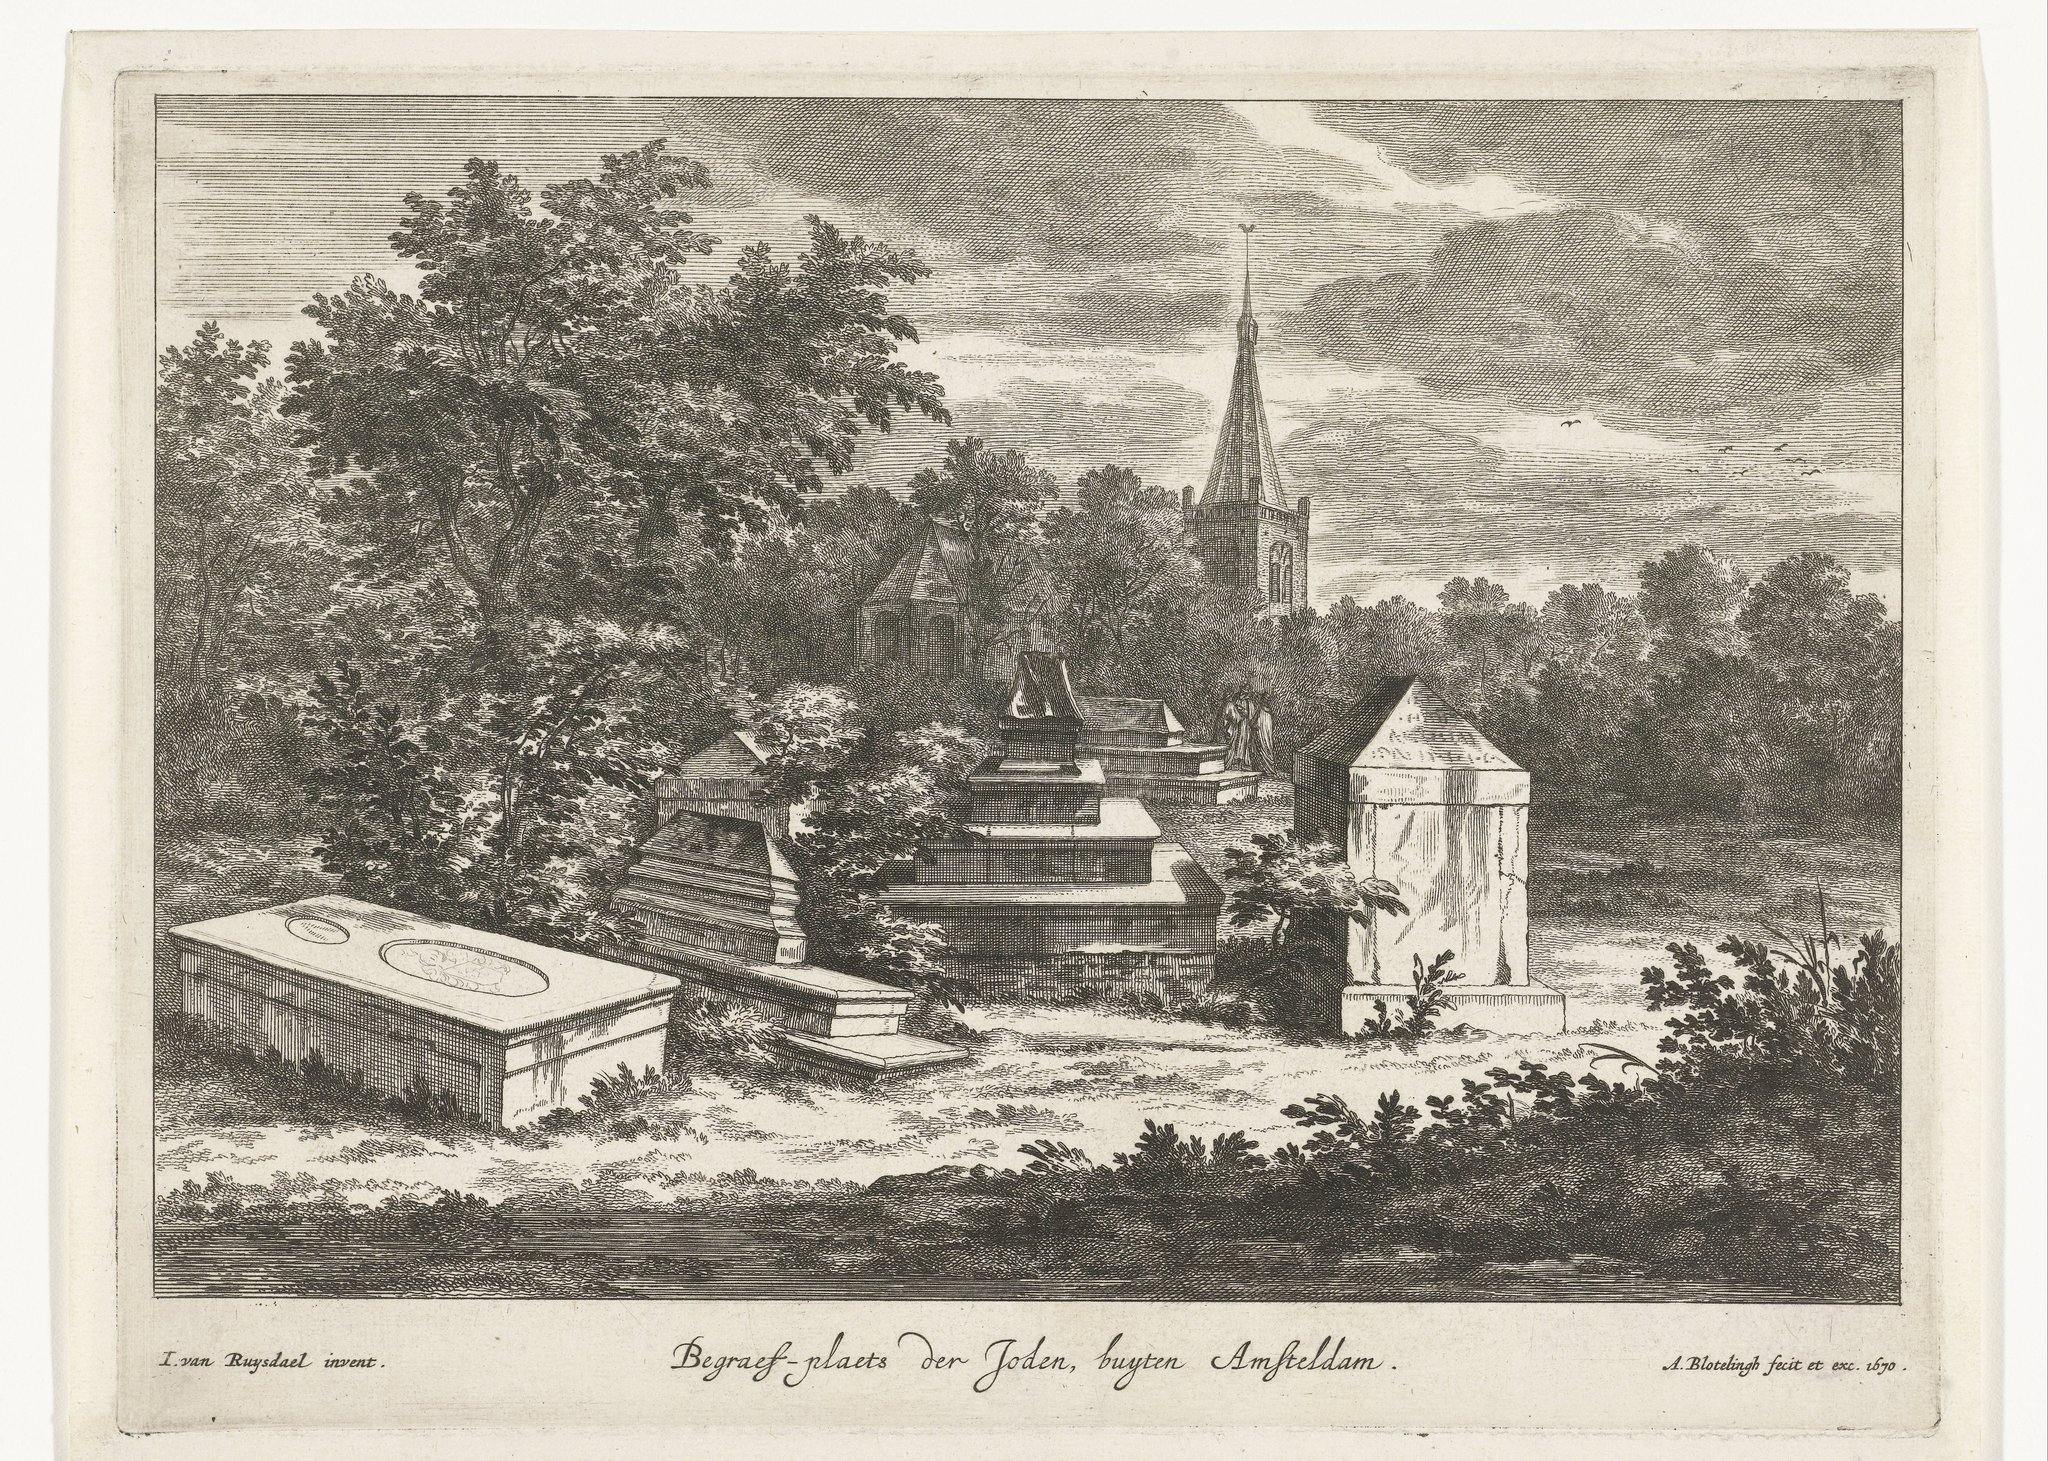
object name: print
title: Begraef-plaets der Joden, buyten Amsteldam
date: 1670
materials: paper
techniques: engraving, etching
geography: amsterdam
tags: 'sephardim' ~ jewish communities, church (exterior), churchyard, cemetery, death and burial ~ jewish customs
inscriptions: collector's mark: Lugt 240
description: Gezicht op de Portugees-Joodse begraafplaats Beth Haim te Ouderkerk aan de Amstel. Op de achtergrond een kerk. In het midden de tombe van Isaac Uriel, links daarvan die van Elia Montalto.